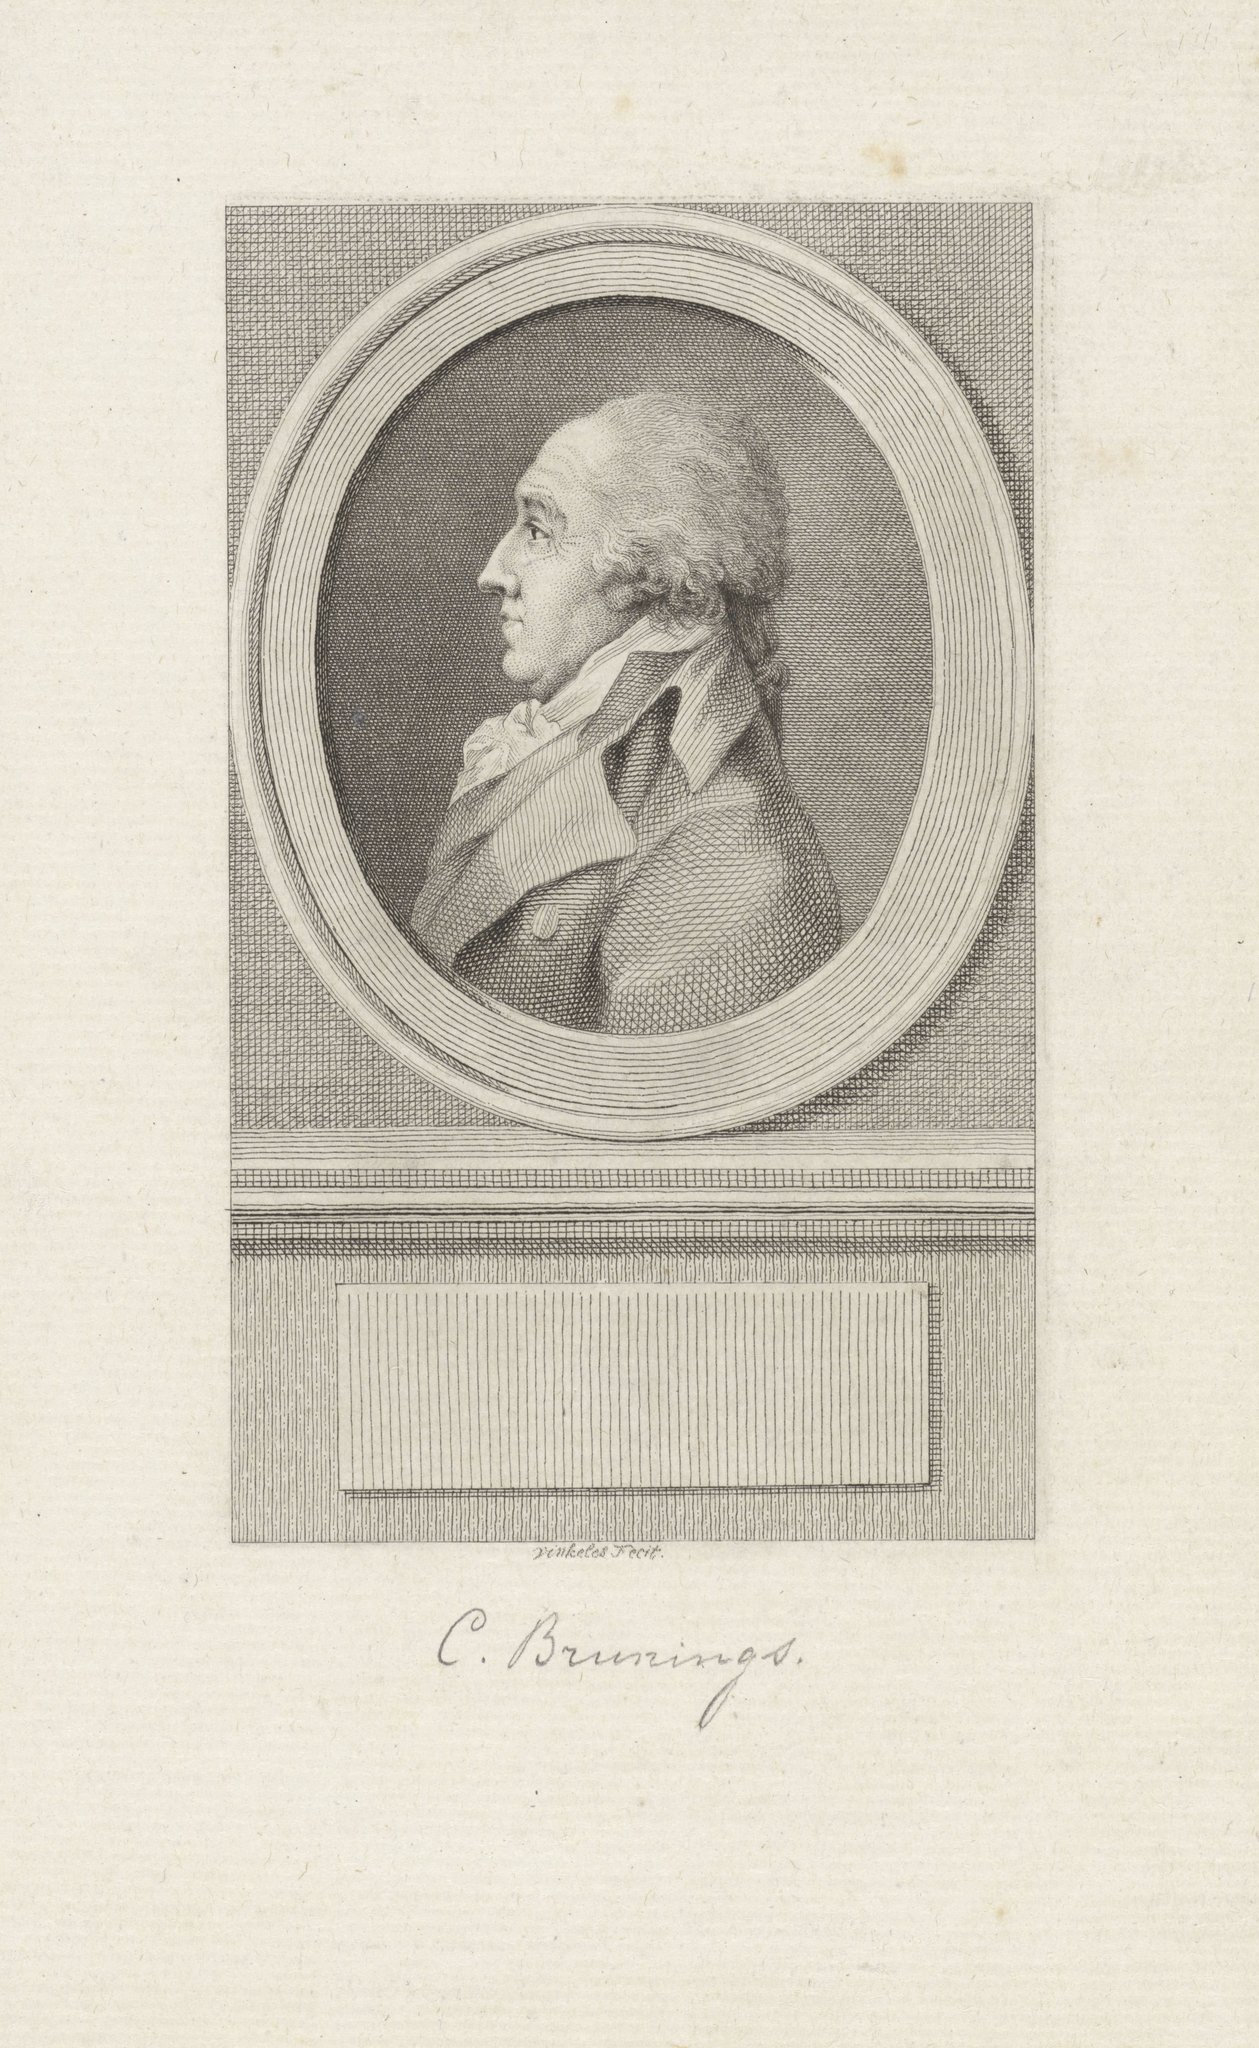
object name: print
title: Portret van Christiaan Brunings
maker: reinier vinkeles (i)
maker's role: draughtsman, print maker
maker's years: 1741-1816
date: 1786-1809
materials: paper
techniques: engraving, etching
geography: amsterdam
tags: the hague, christiaan l. brunings (i)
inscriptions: collector's mark: Lugt 2228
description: Latere staat prent gebruikt als boekillustratie in: Wagenaar, Jan. Vaderlandsche historie, (...) ten vervolge van Wagenaars Vaderlandsche historie. Dl. 1-43. Amsterdam: Johannes Allart, 1786-1809.